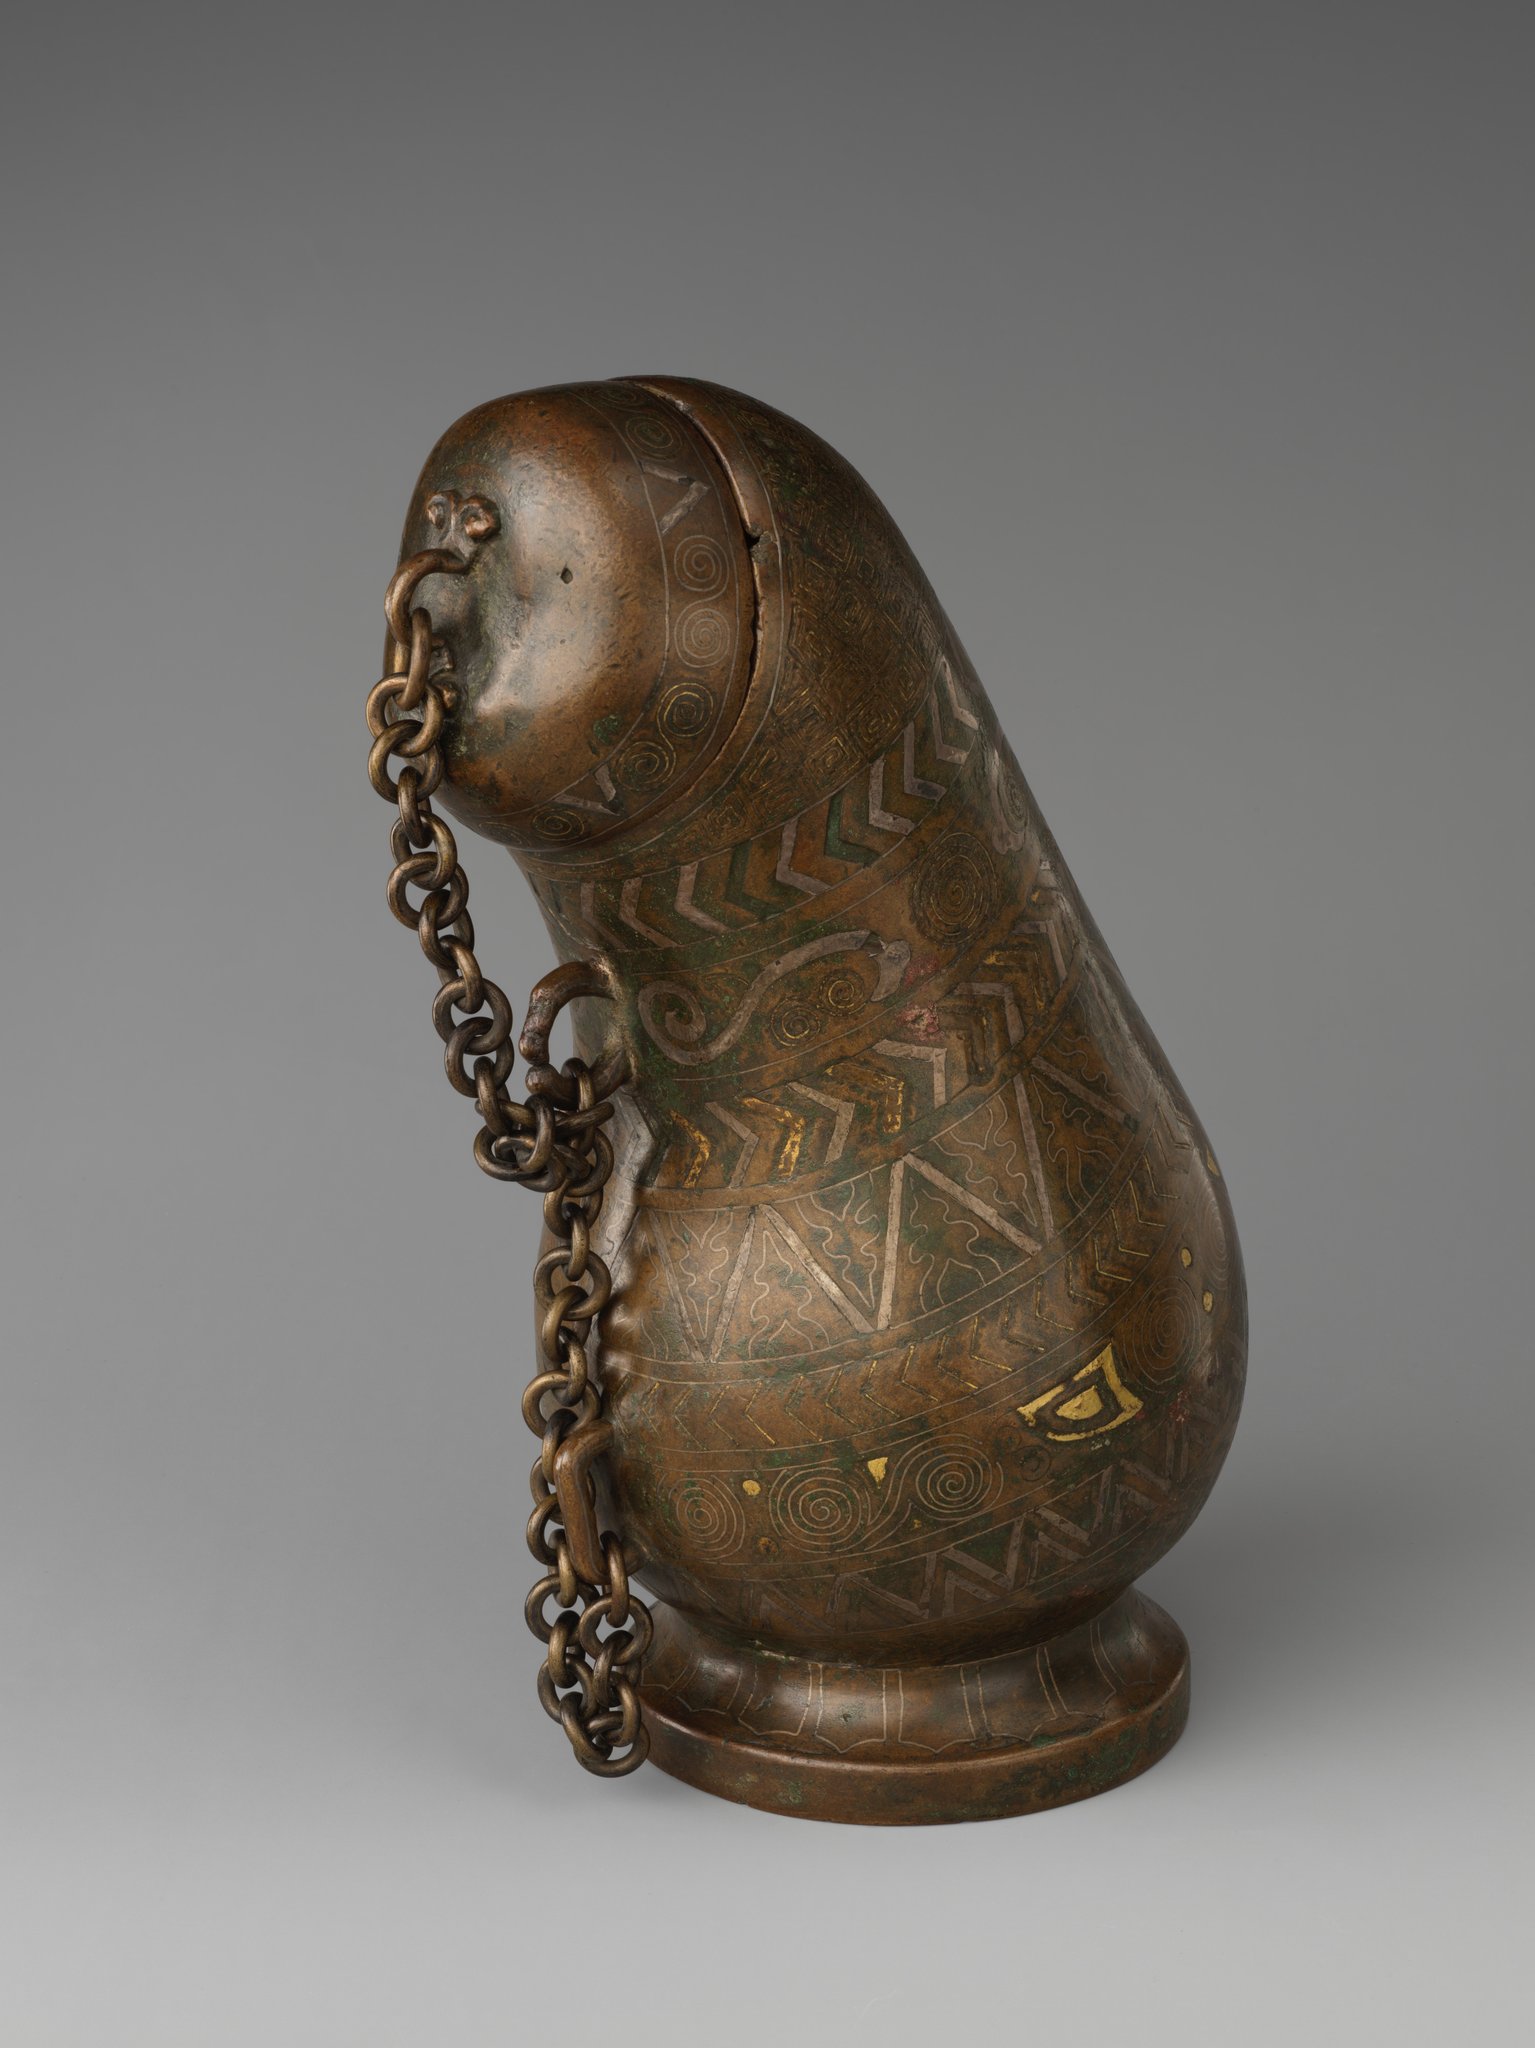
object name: wine vessel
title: Pouch-shaped vessel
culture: chinese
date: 1501-1700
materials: copper alloy, gold, silver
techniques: inlay